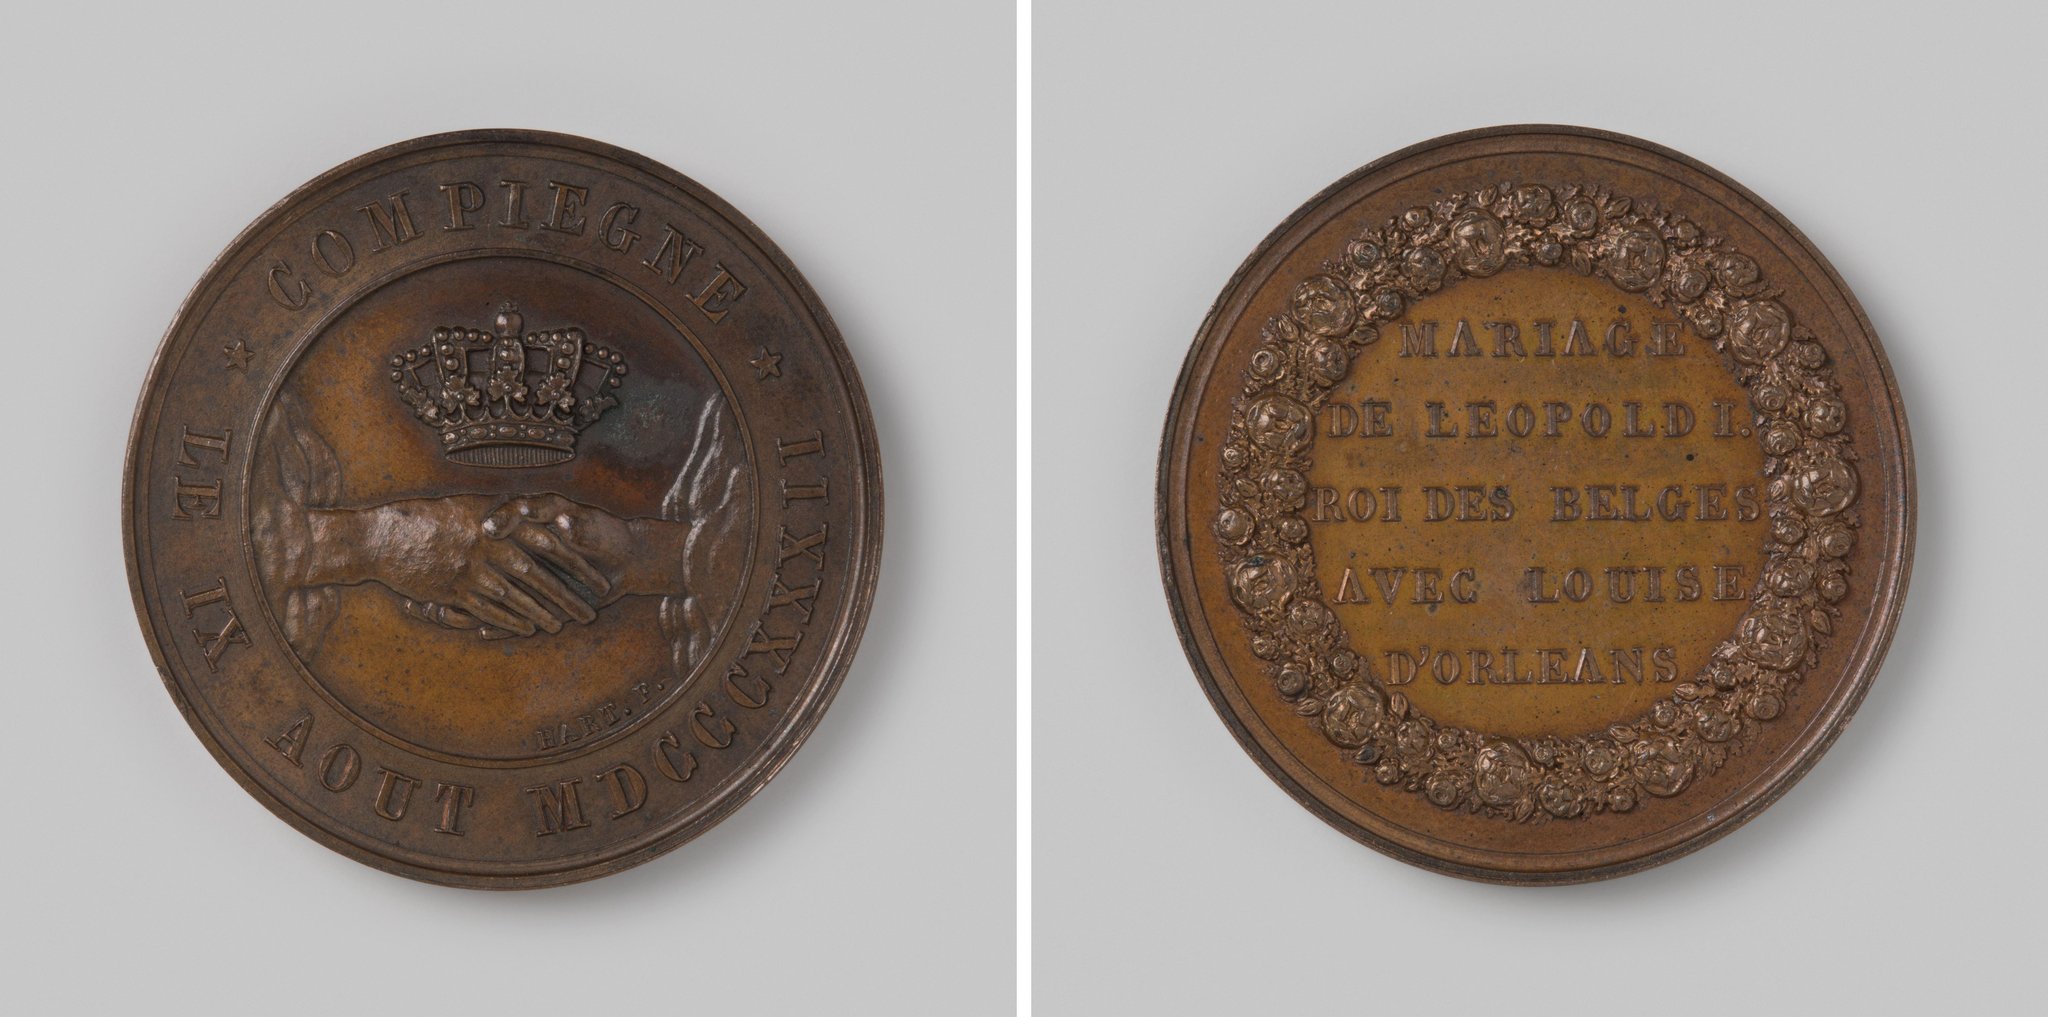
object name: history medal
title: Huwelijk van Leopold I, koning der Belgen en Louise van Orleans te Compiegne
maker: laurent joseph hart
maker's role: die cutter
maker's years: 1810-1860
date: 1832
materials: bronze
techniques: striking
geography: brussels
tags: louise marie van orléans (koningin van belgië), laeken, leopold i (koning der belgen)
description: Bronzen penning. Voorzijde: twee ineen geslagen handen uit wolken onder kroon binnen omschrift. Keerzijde: opschrift binnen rozekrans.